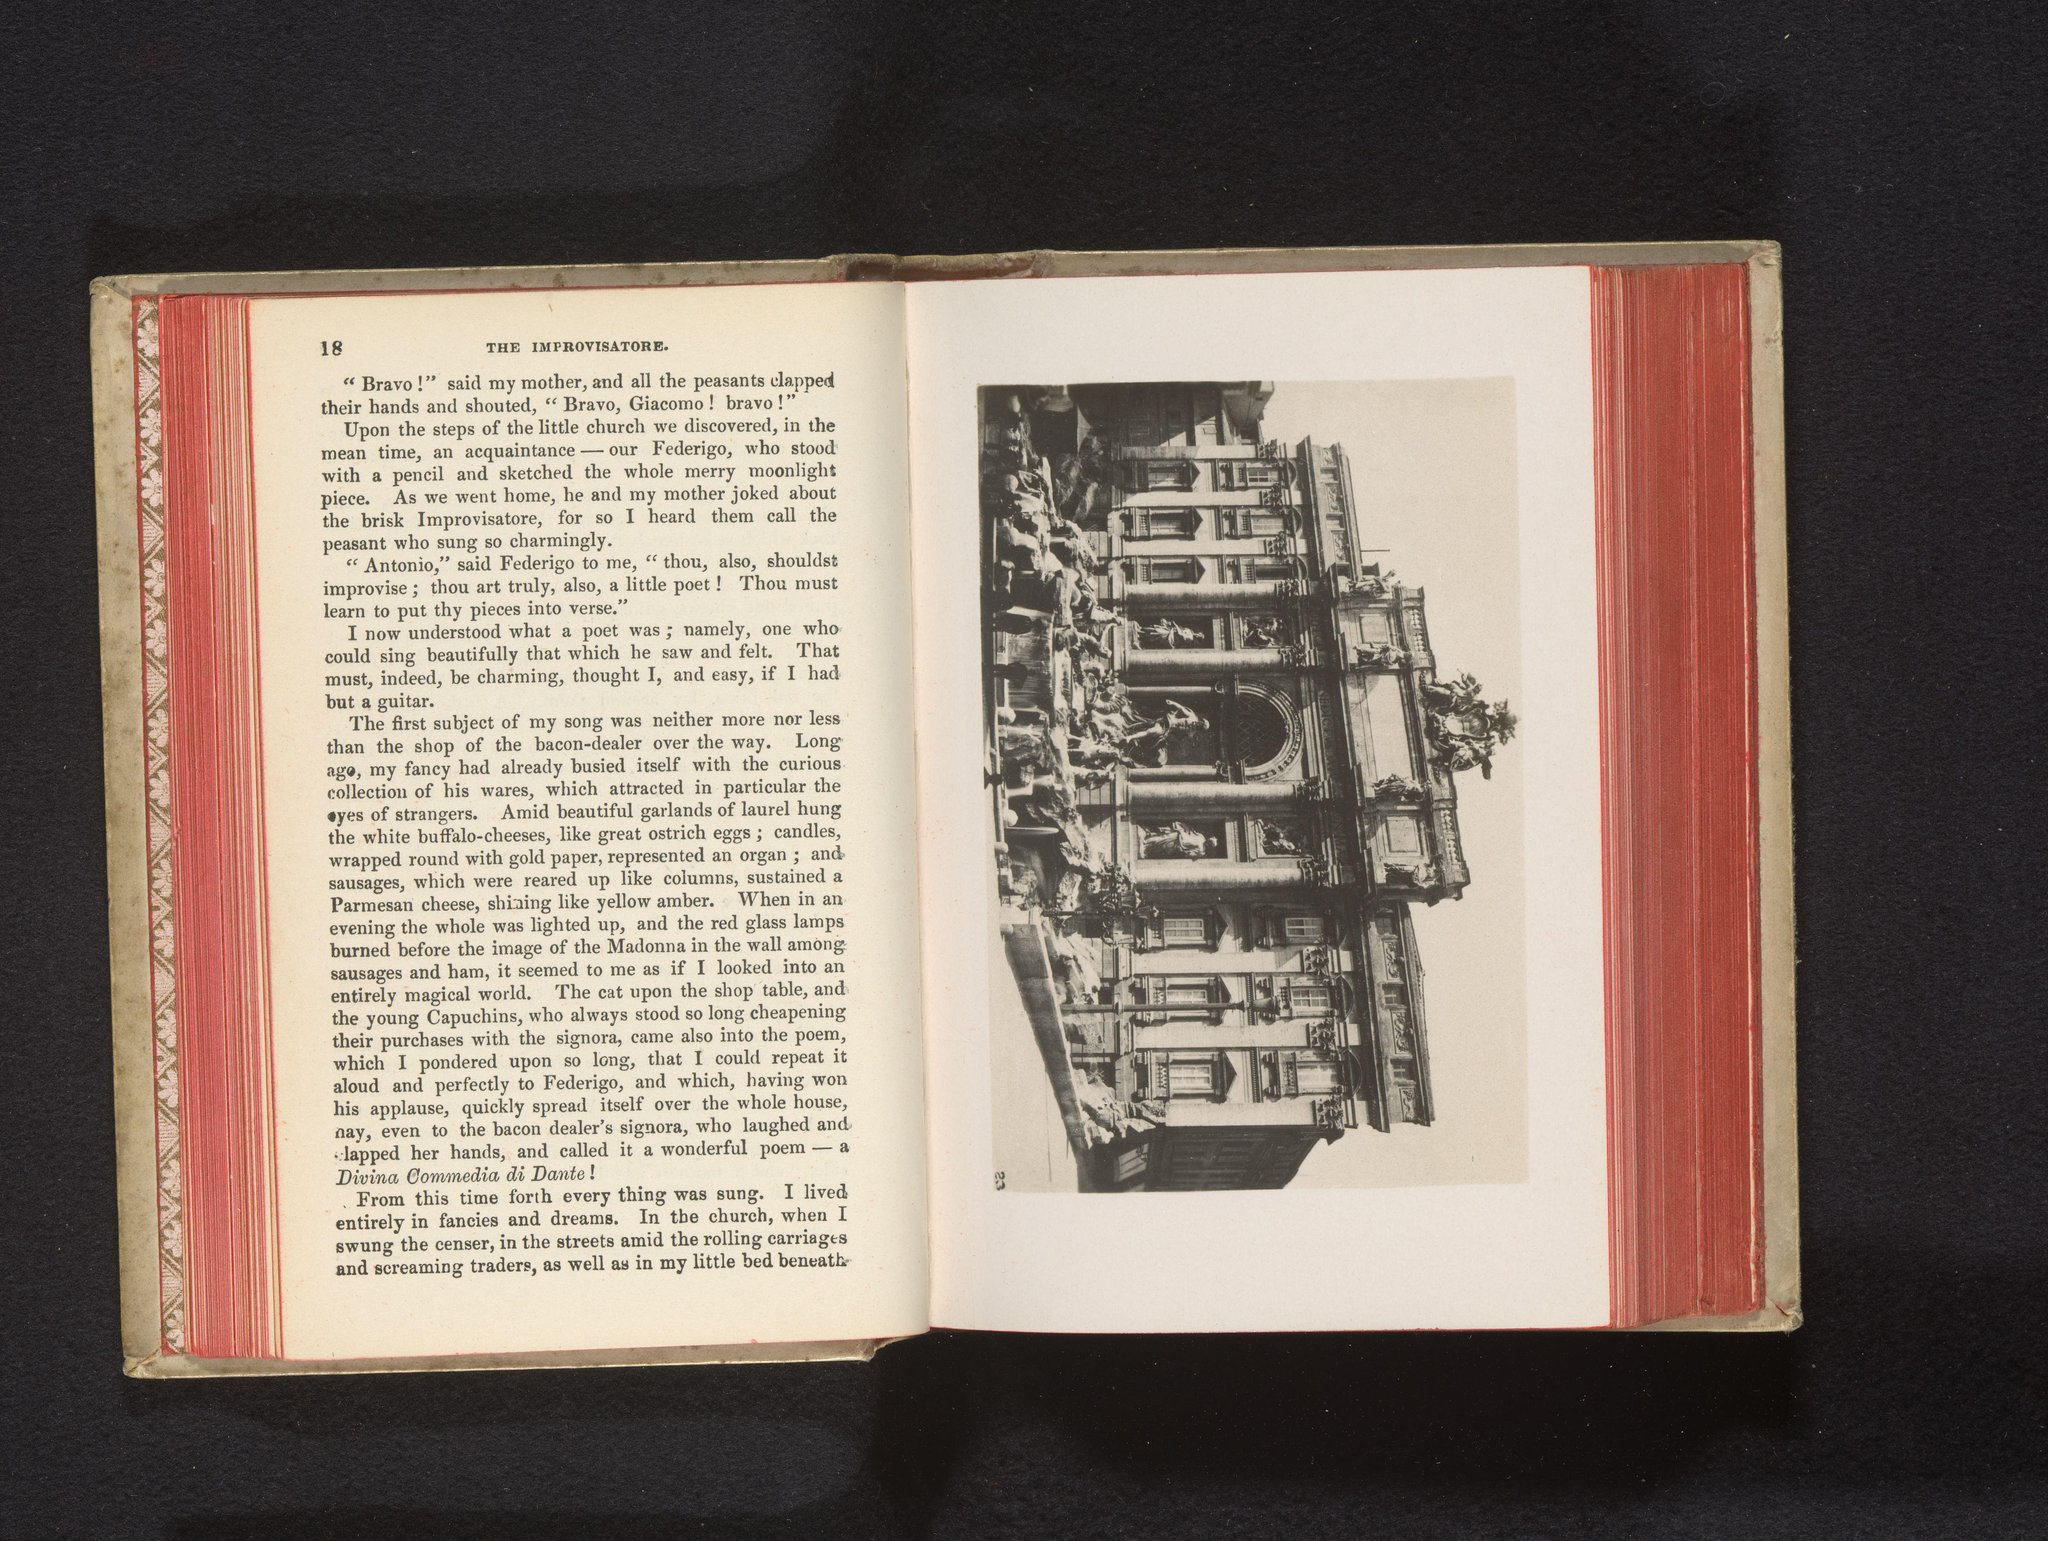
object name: page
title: Trevifontein te Rome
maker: Anonymous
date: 1870-1880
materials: photographic support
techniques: gelatin silver print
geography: rome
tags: ornamental fountain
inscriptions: number: ‘23’